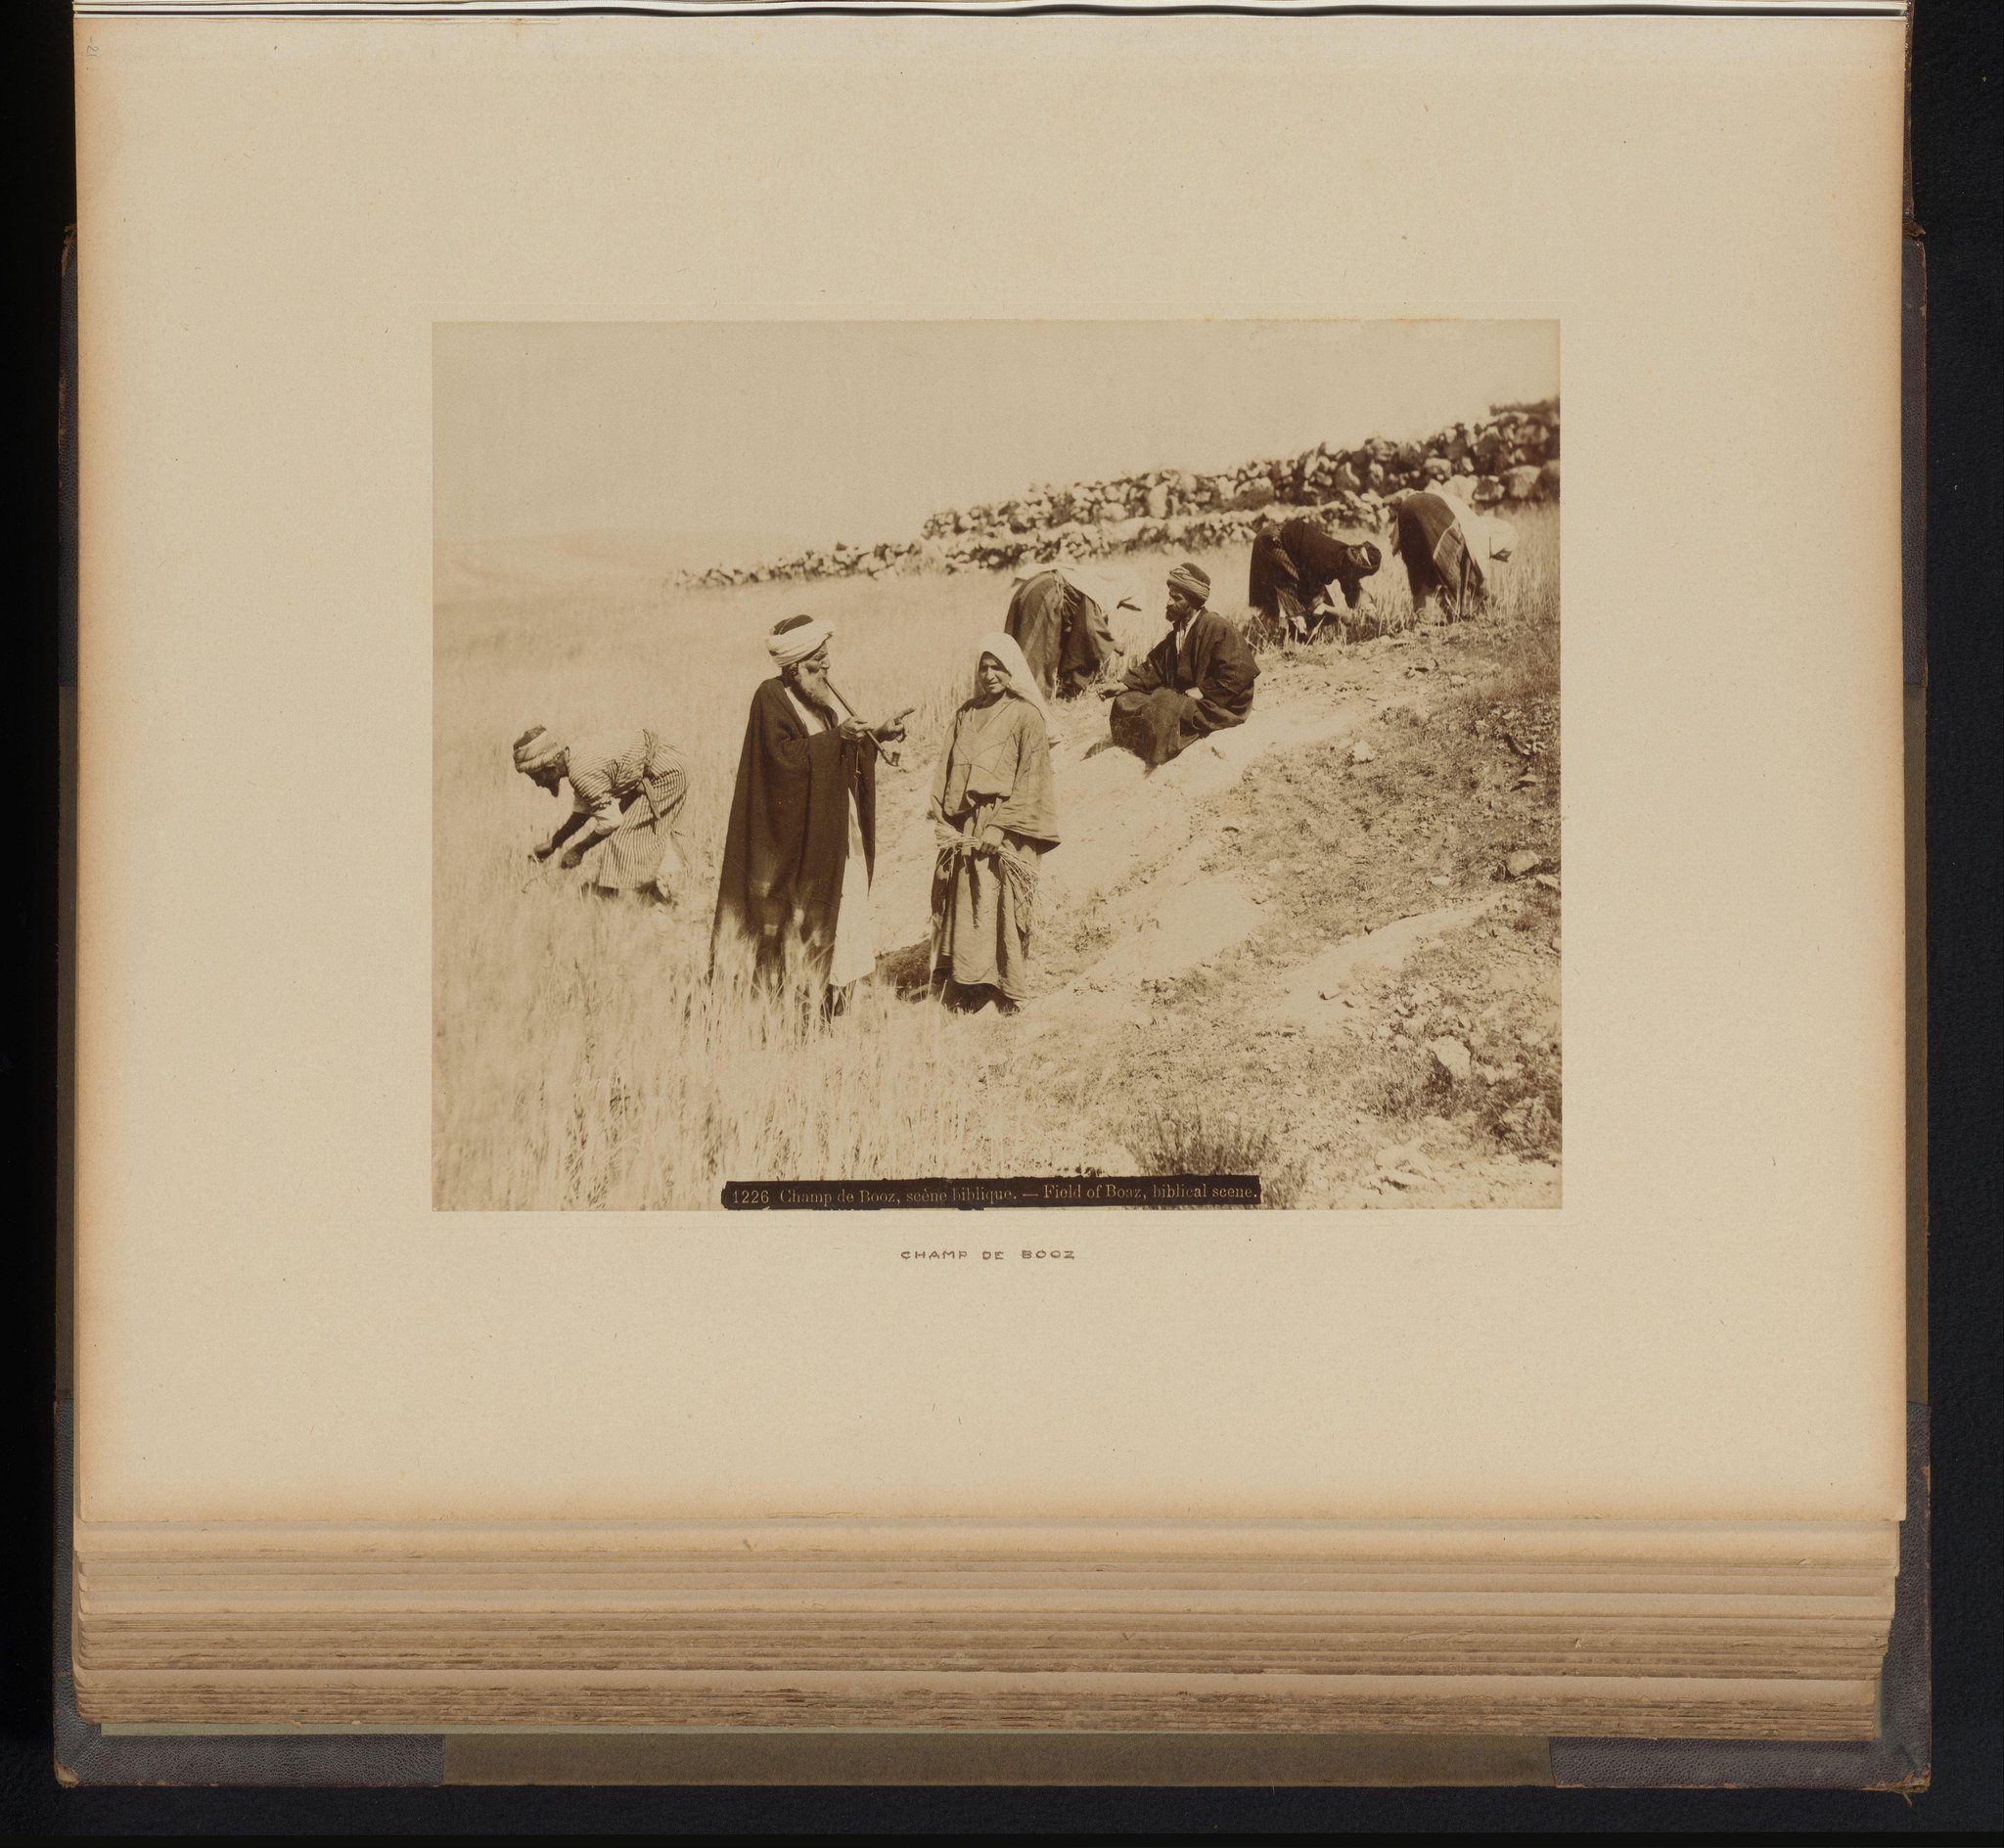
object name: photograph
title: Mensen op een graanveld nabij Bethlehem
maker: Anonymous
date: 1851-1910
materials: paper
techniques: albumen print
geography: bethlehem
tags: field filled with a crop, cereal, grain, corn (grass with grains, grown for food, e.g.: wheat, rice, rye, oats, maize, buckwheat, millet)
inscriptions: number: ‘1226’